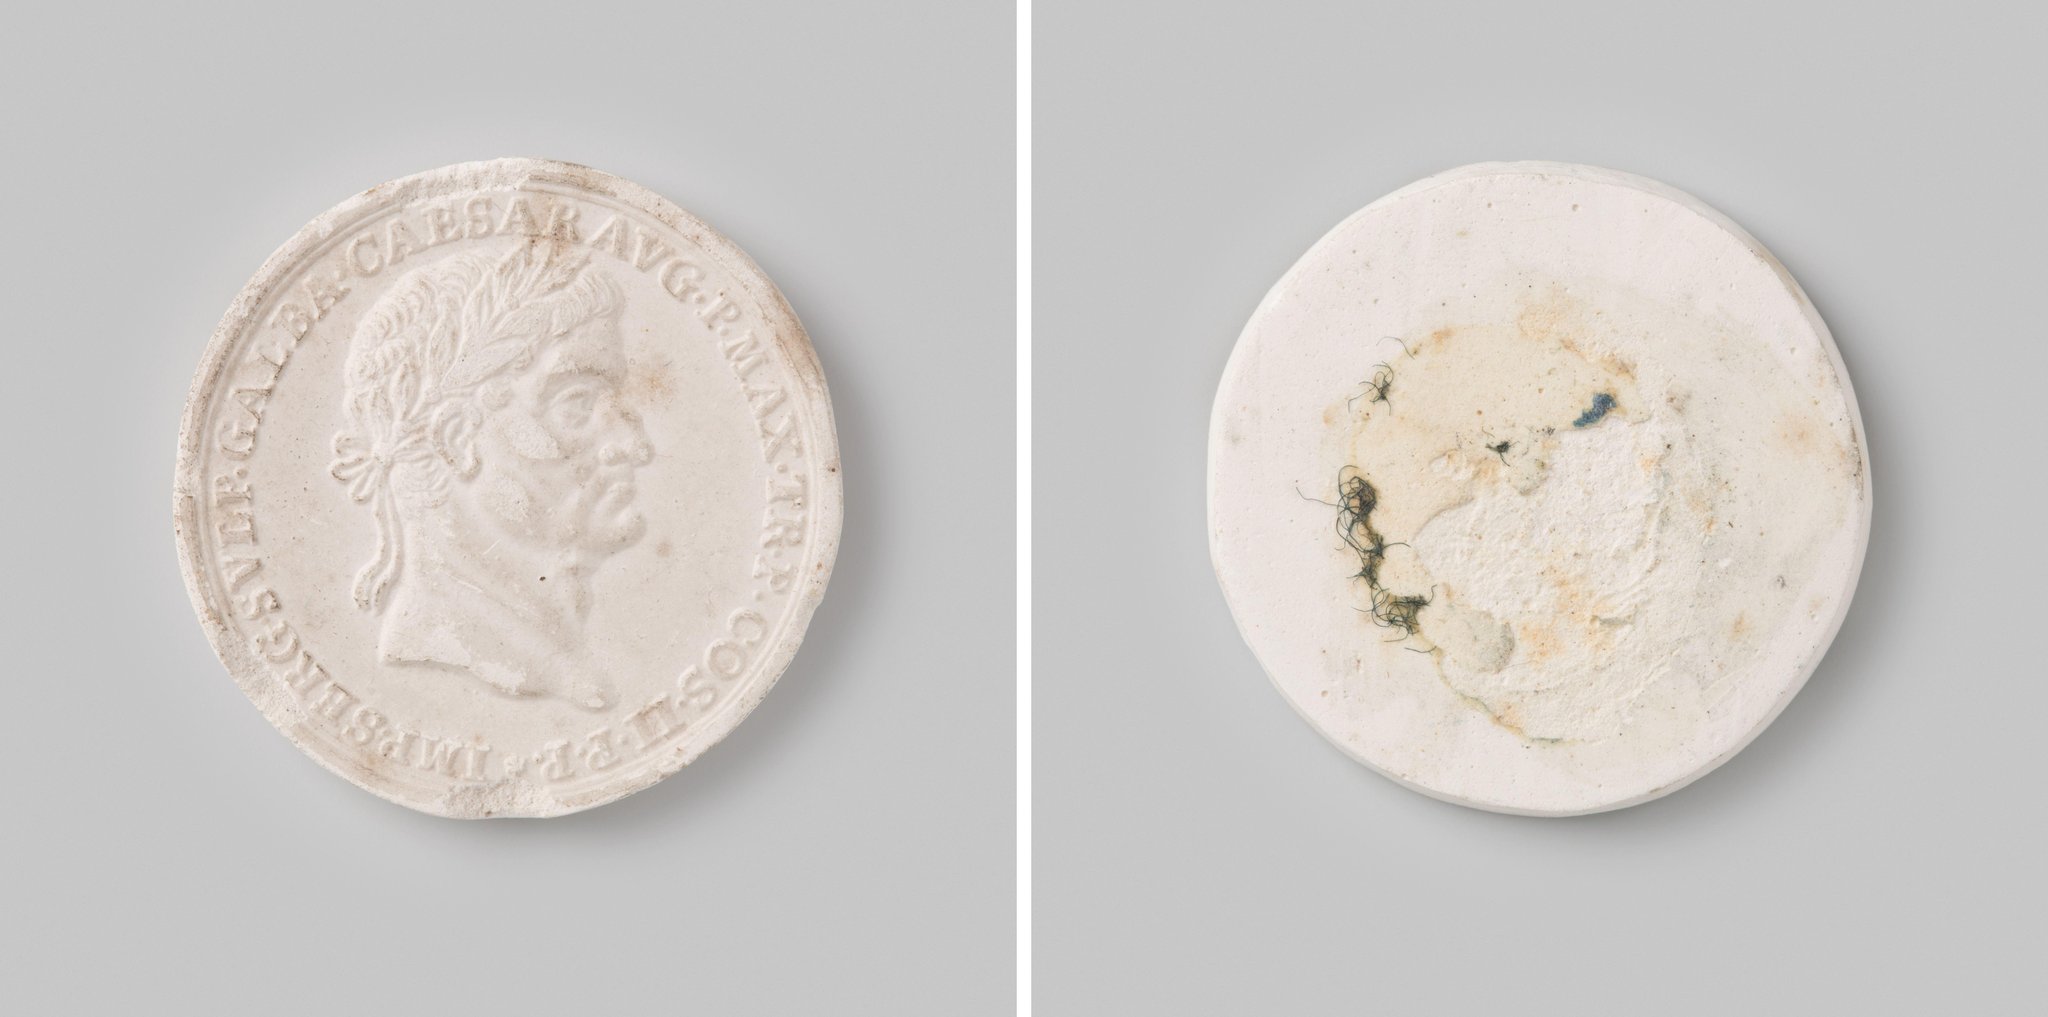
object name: history medal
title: Renaissance-imitatie van een munt van de Romeinse keizer Galba, afgietsel in gips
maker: Anonymous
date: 1500-1800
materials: gypsum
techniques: casting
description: Eenzijdig gipsen afgietsel van een imitatiemunt met het portret van Keizer Galba naar rechts met omschrift, aan de achterkant lijm- en textielresten.